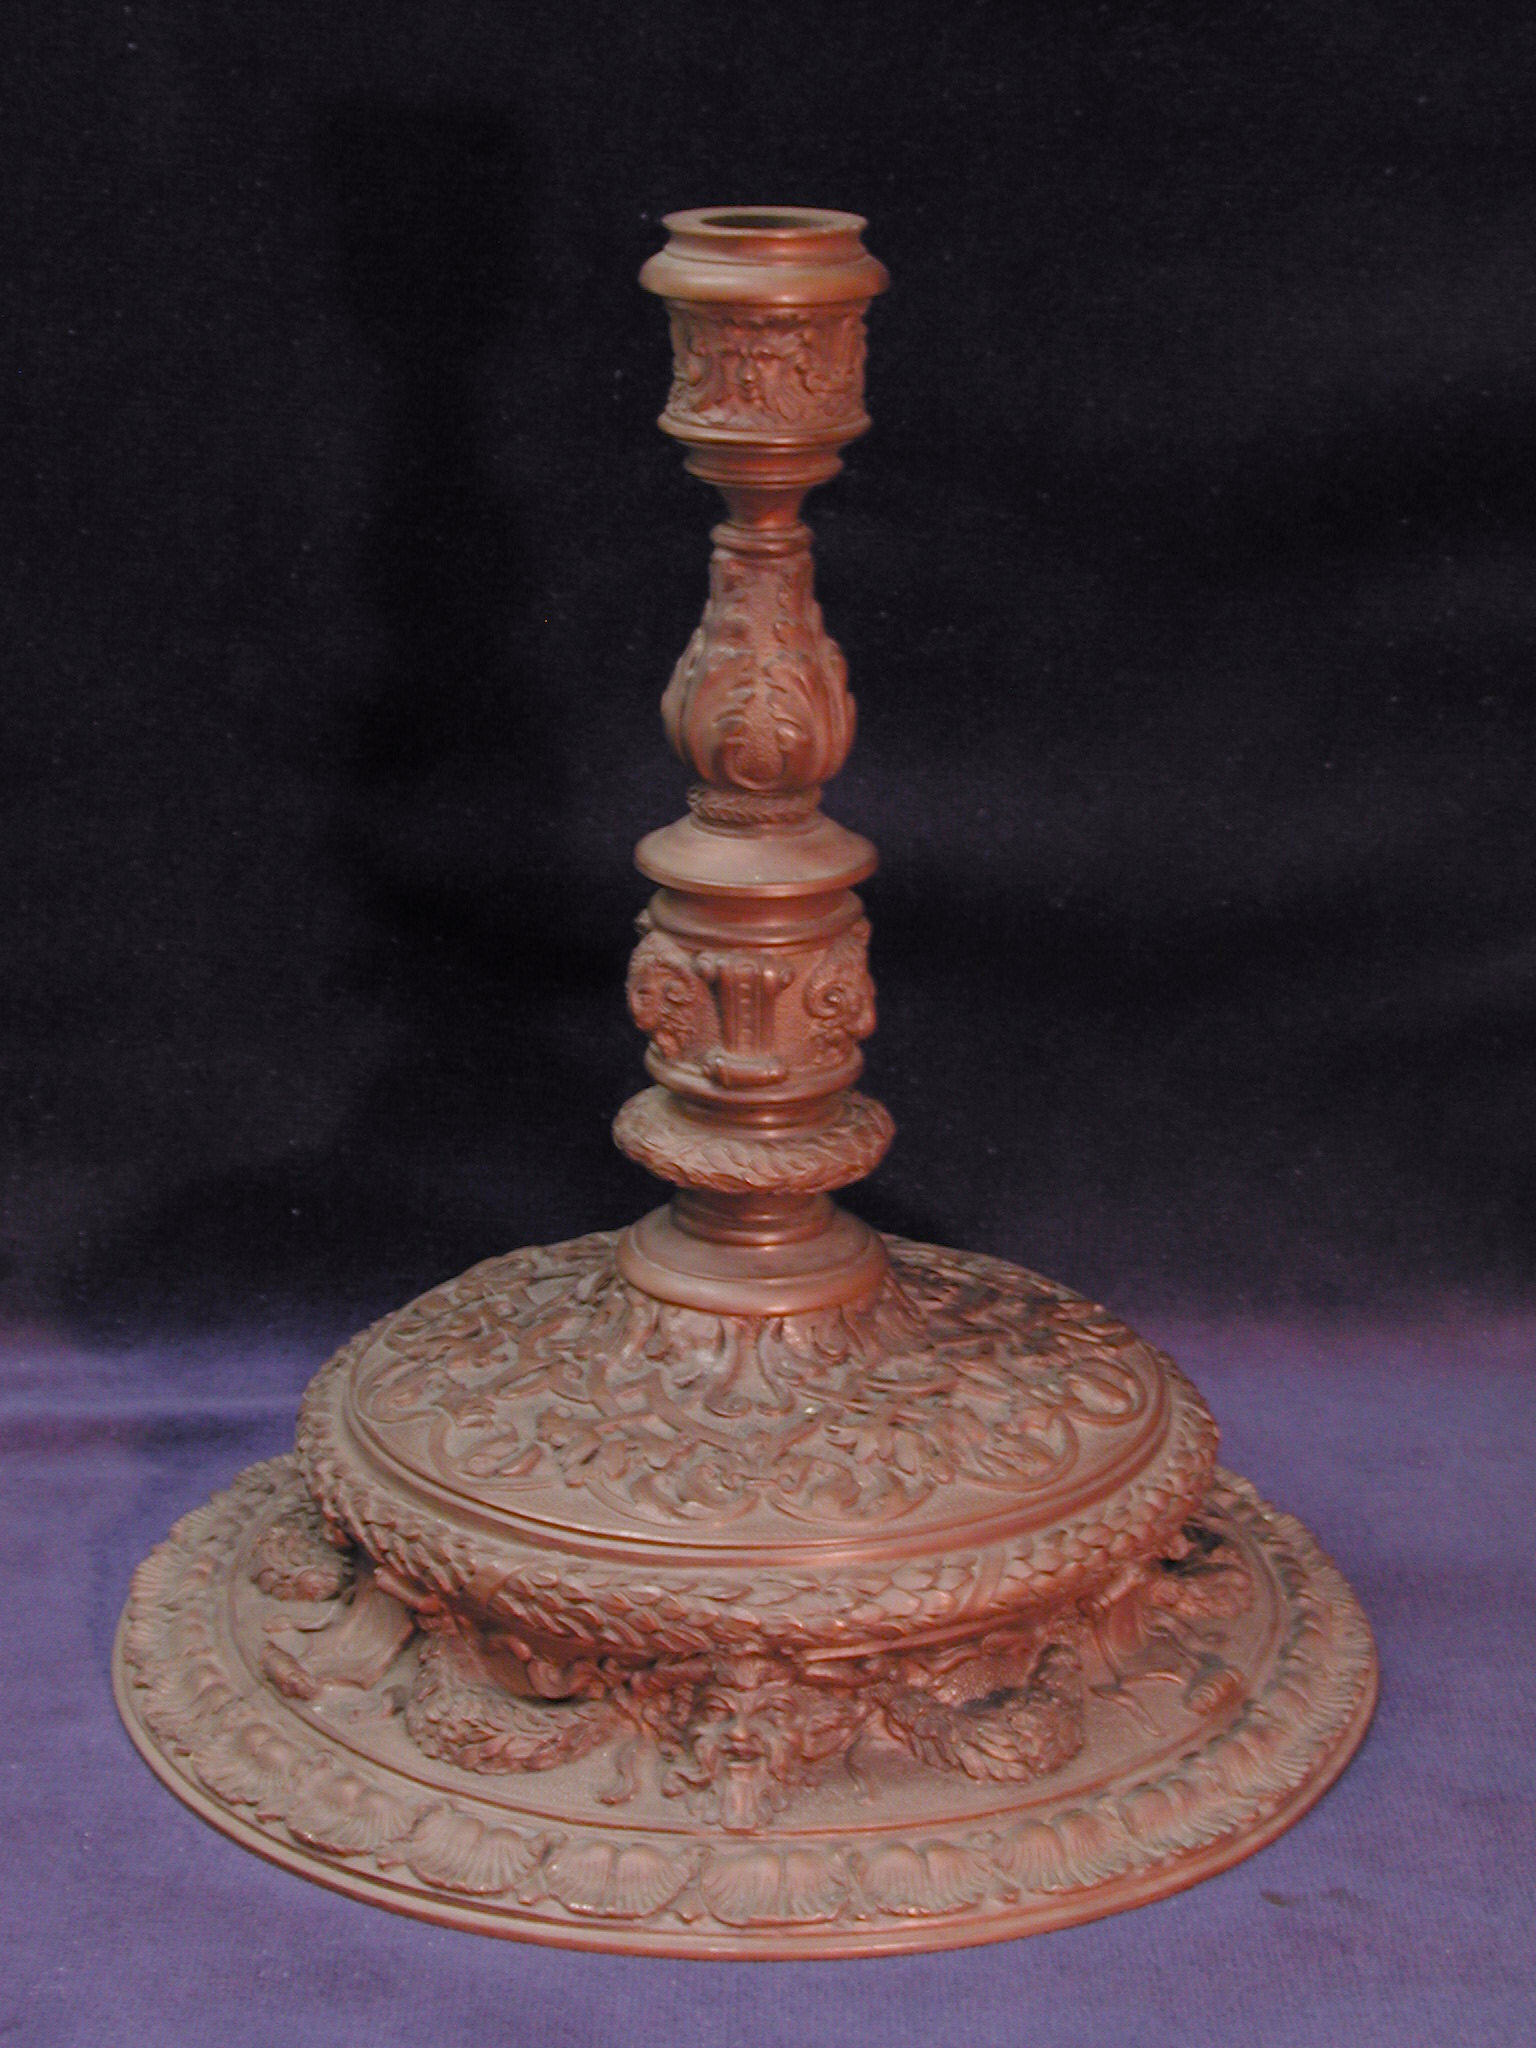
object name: candlestick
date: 1801-1900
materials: bronze